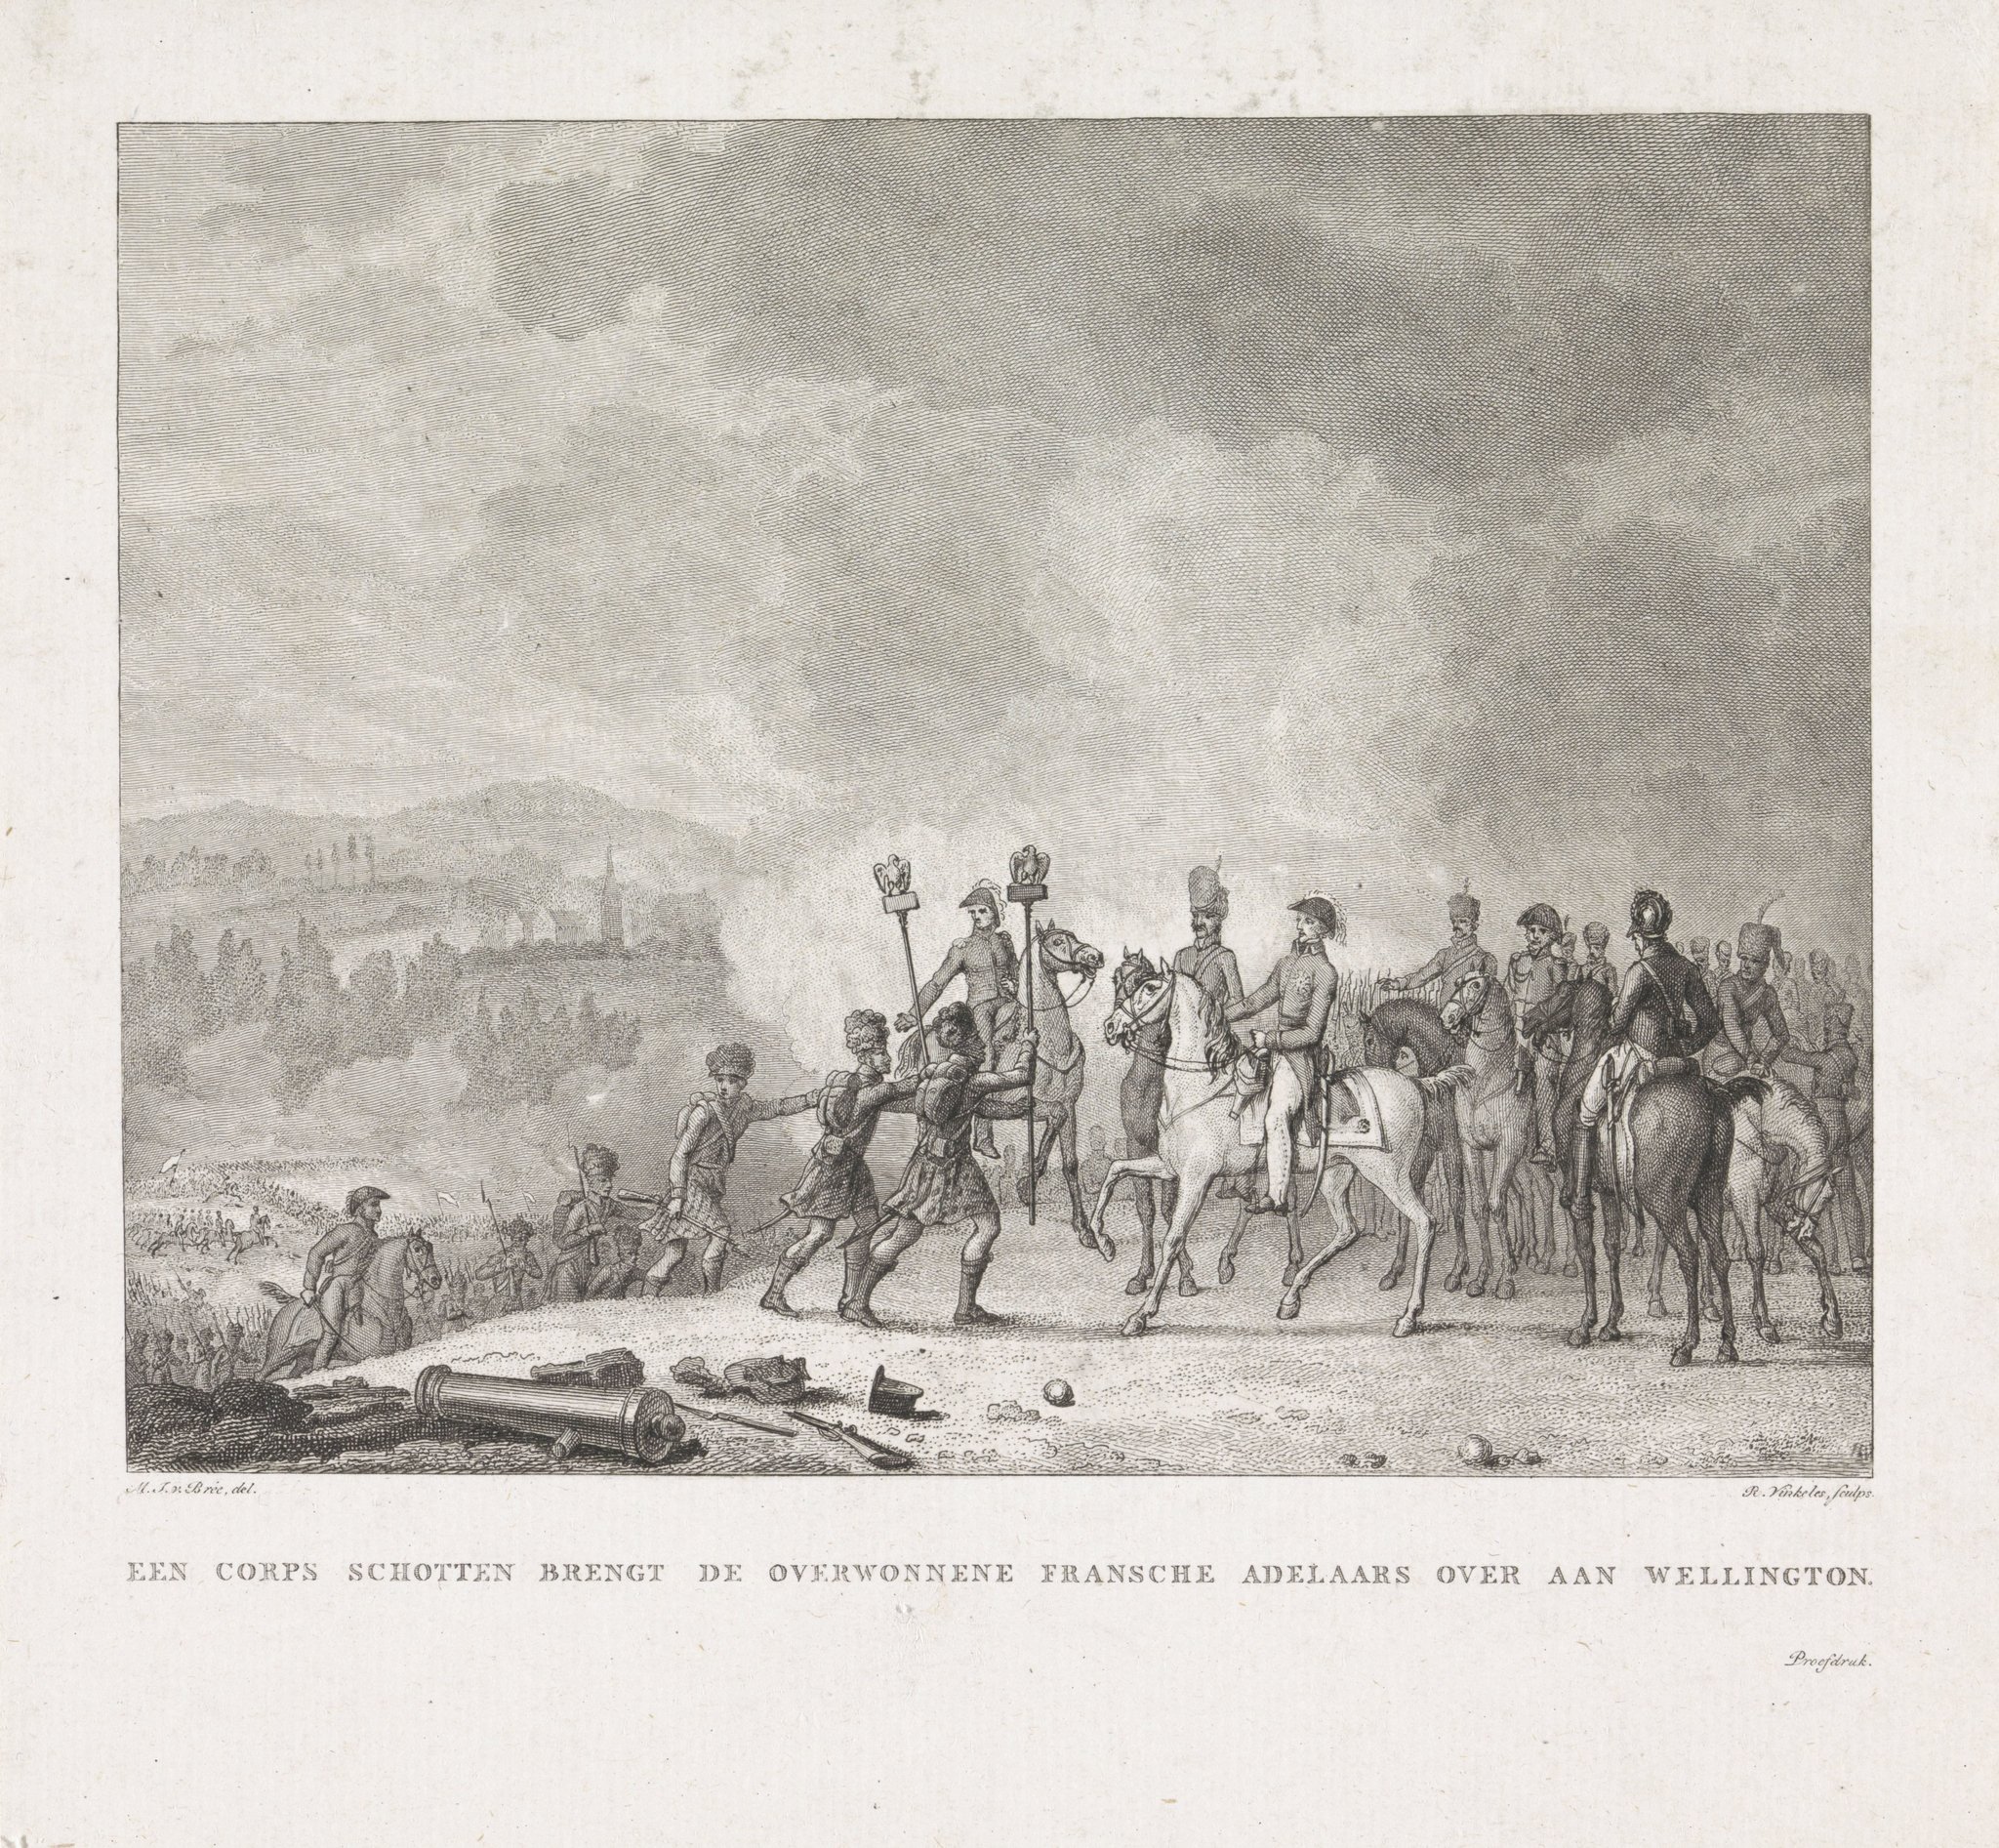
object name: print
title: Een corps Schotten brengt de overwonne Fransche adelaars over aan Wellington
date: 1815-1816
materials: paper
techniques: engraving, etching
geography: netherlands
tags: walmer castle, arthur wellesley of wellington, (military) flags and standards (+ land forces), battle (+ land forces), waterloo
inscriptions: collector's mark: Lugt 2228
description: Een korps Schotten presenteert twee veroverde Franse standaarden met adelaars aan de hertog van Wellington, tijdens de slag bij Waterloo, op 18 juni 1815. Onderdeel van een groep illustraties van gebeurtenissen rond en tijdens de veldslagen bij Quatre-Bras en Waterloo, 16-18 juni 1815.